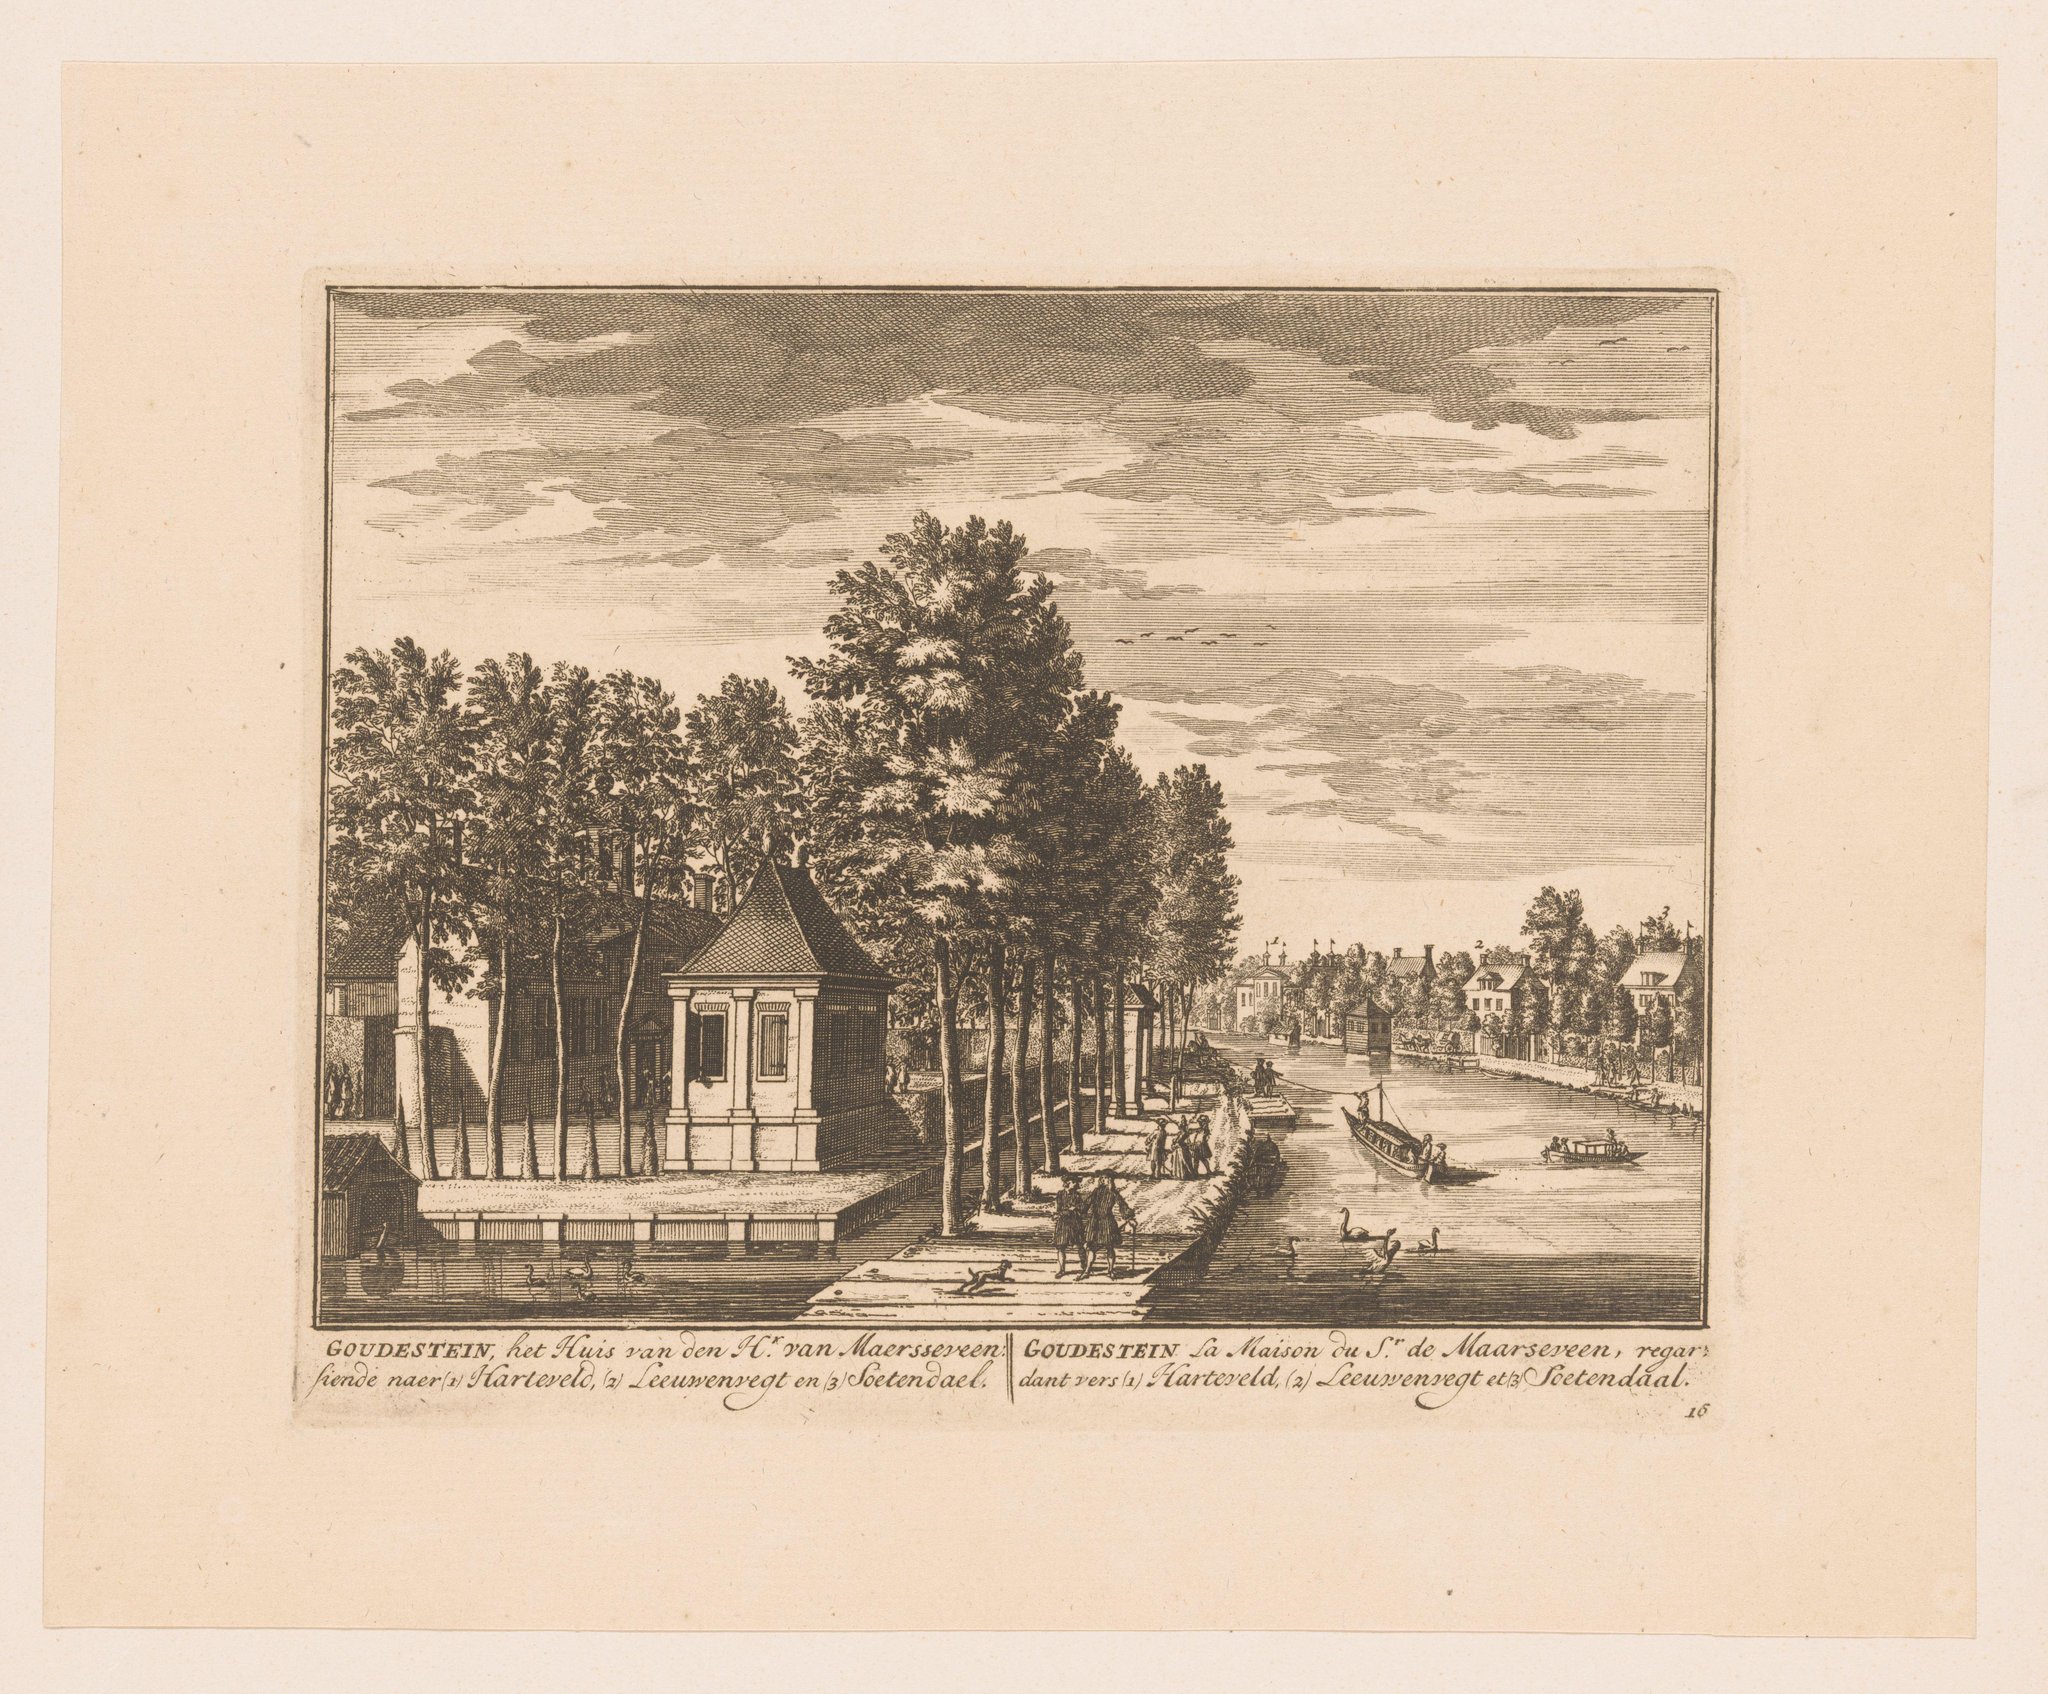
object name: print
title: Goudestein, het Huis van den Hr. van Maersseveen; siende naer (1) Harteveld, (2) Leeuwenvegt en (3) Soetendael / Goudestein La Maison du Sr. de Maarseveen, regardant vers (1) Harteveld, (2) Leeuwenvegt et (3) Soetendaal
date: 1719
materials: paper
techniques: etching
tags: river, rural housing, e.g. country-house, villa, cottage, maarssen, vecht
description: Prent uit: De zegepraalende Vecht, vertoonende verscheidene gesichten van lustplaatsen, heeren huysen en dorpen, beginnende van Uitrecht en met Muyden besluytende. Amsterdam: Wed. Nicolaes Visscher, 1719.